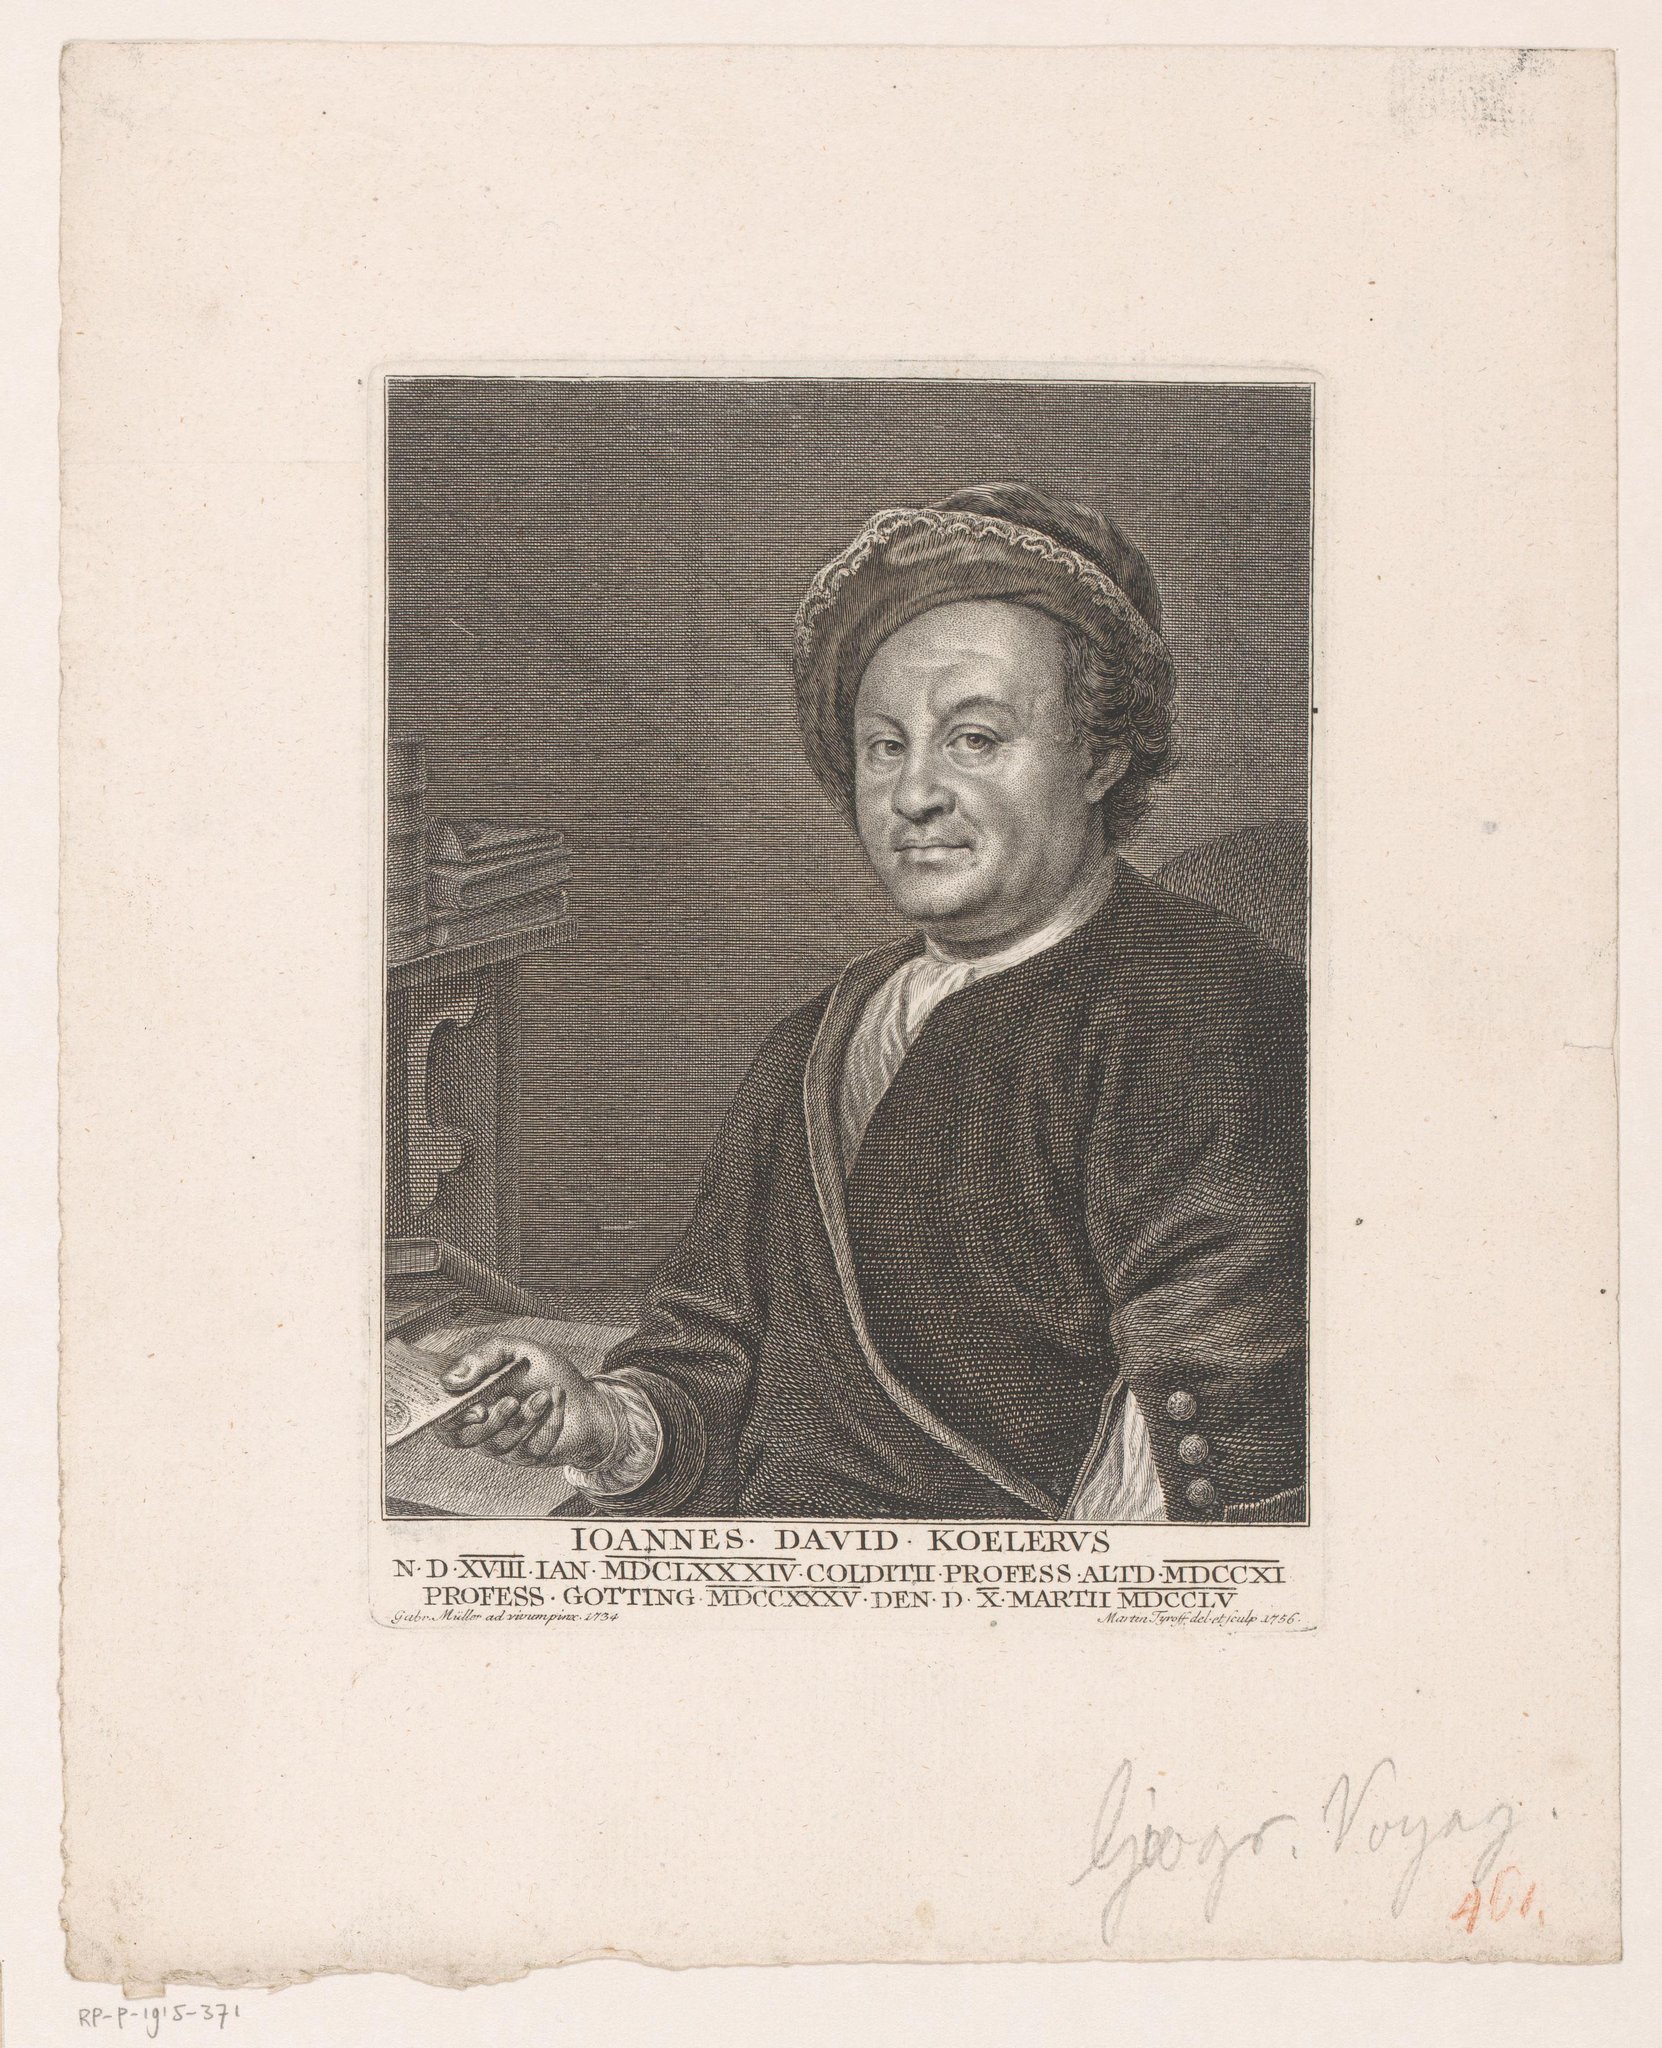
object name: print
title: Portret van Johann David Köhler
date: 1756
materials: paper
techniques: engraving, etching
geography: germany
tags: historical persons, book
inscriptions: collector's mark: Lugt 2228, number: ‘461’